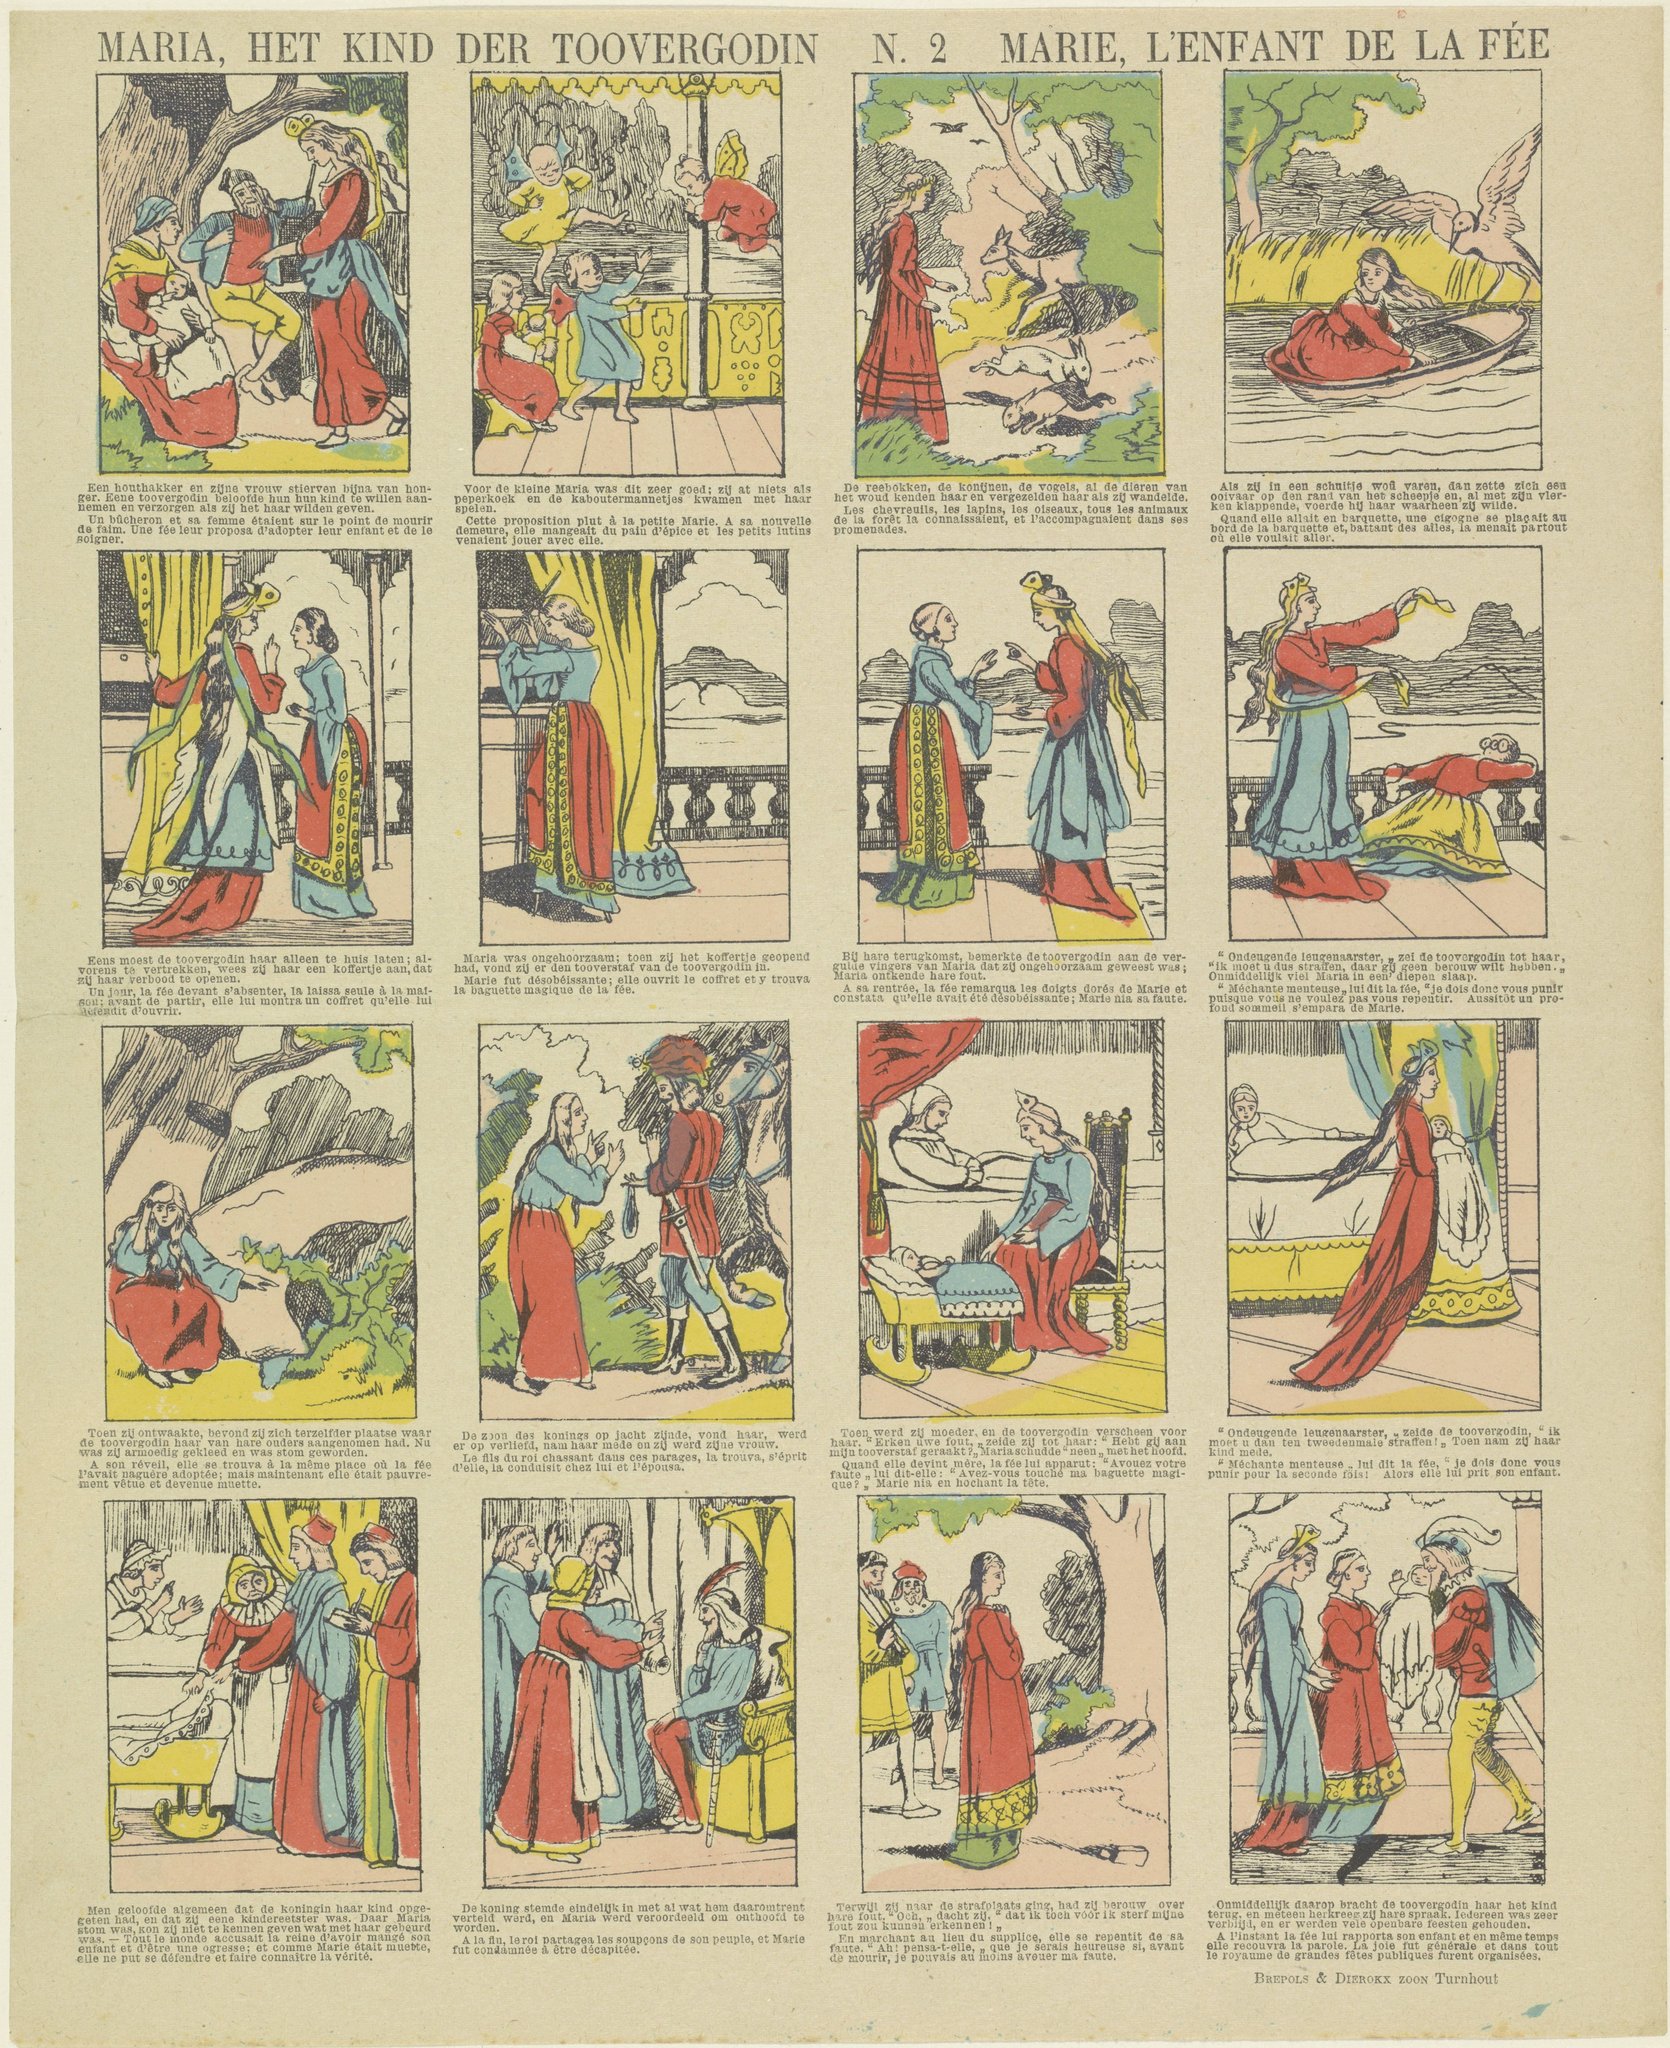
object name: print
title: Maria, het kind der toovergodin / Marie, l'enfant de la fée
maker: Anonymous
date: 1833-1911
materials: paper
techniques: lithograph, letterpress printing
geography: turnhout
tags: tales and fairy tales, representations ~ goddesses, demi-goddesses, heroines, etc. (non-christian religions)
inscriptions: collector's mark: Lugt 2760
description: Blad met 16 voorstellingen uit het sprookje van Maria, het kind van een tovergodin. Onder elke afbeelding een onderschrift in het Nederlands en in het Frans. Genummerd midden boven: N. 2.